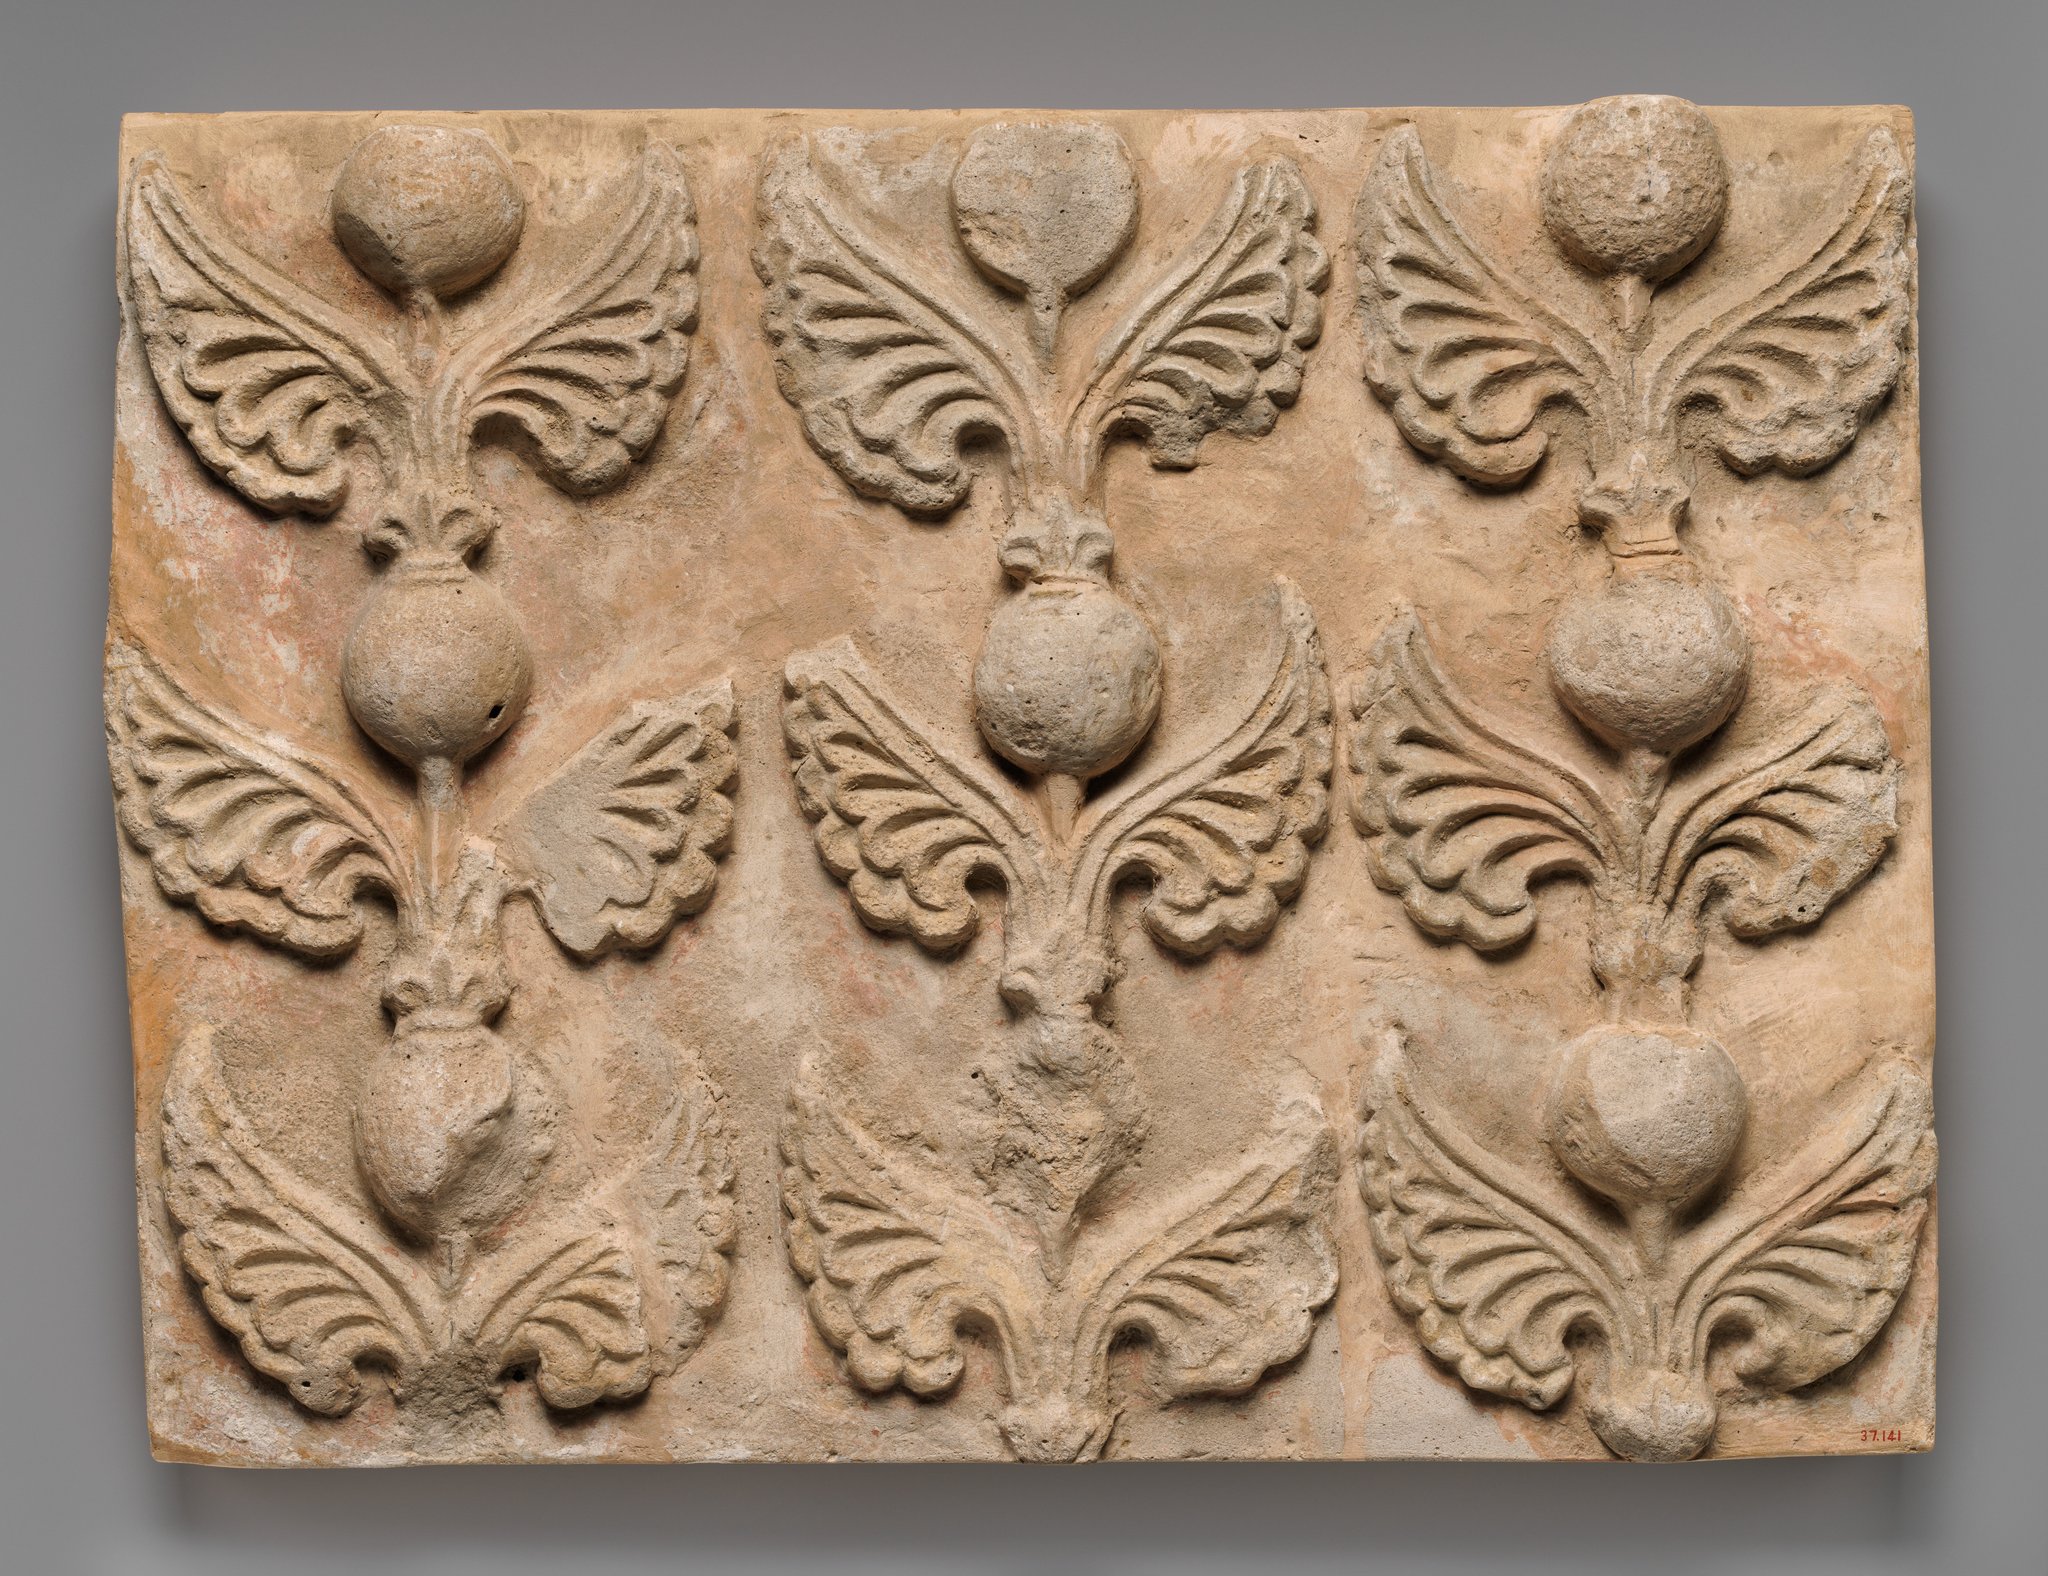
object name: relief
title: Frieze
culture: sasanian or islamic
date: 601-800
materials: plaster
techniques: gilding, painting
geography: iran